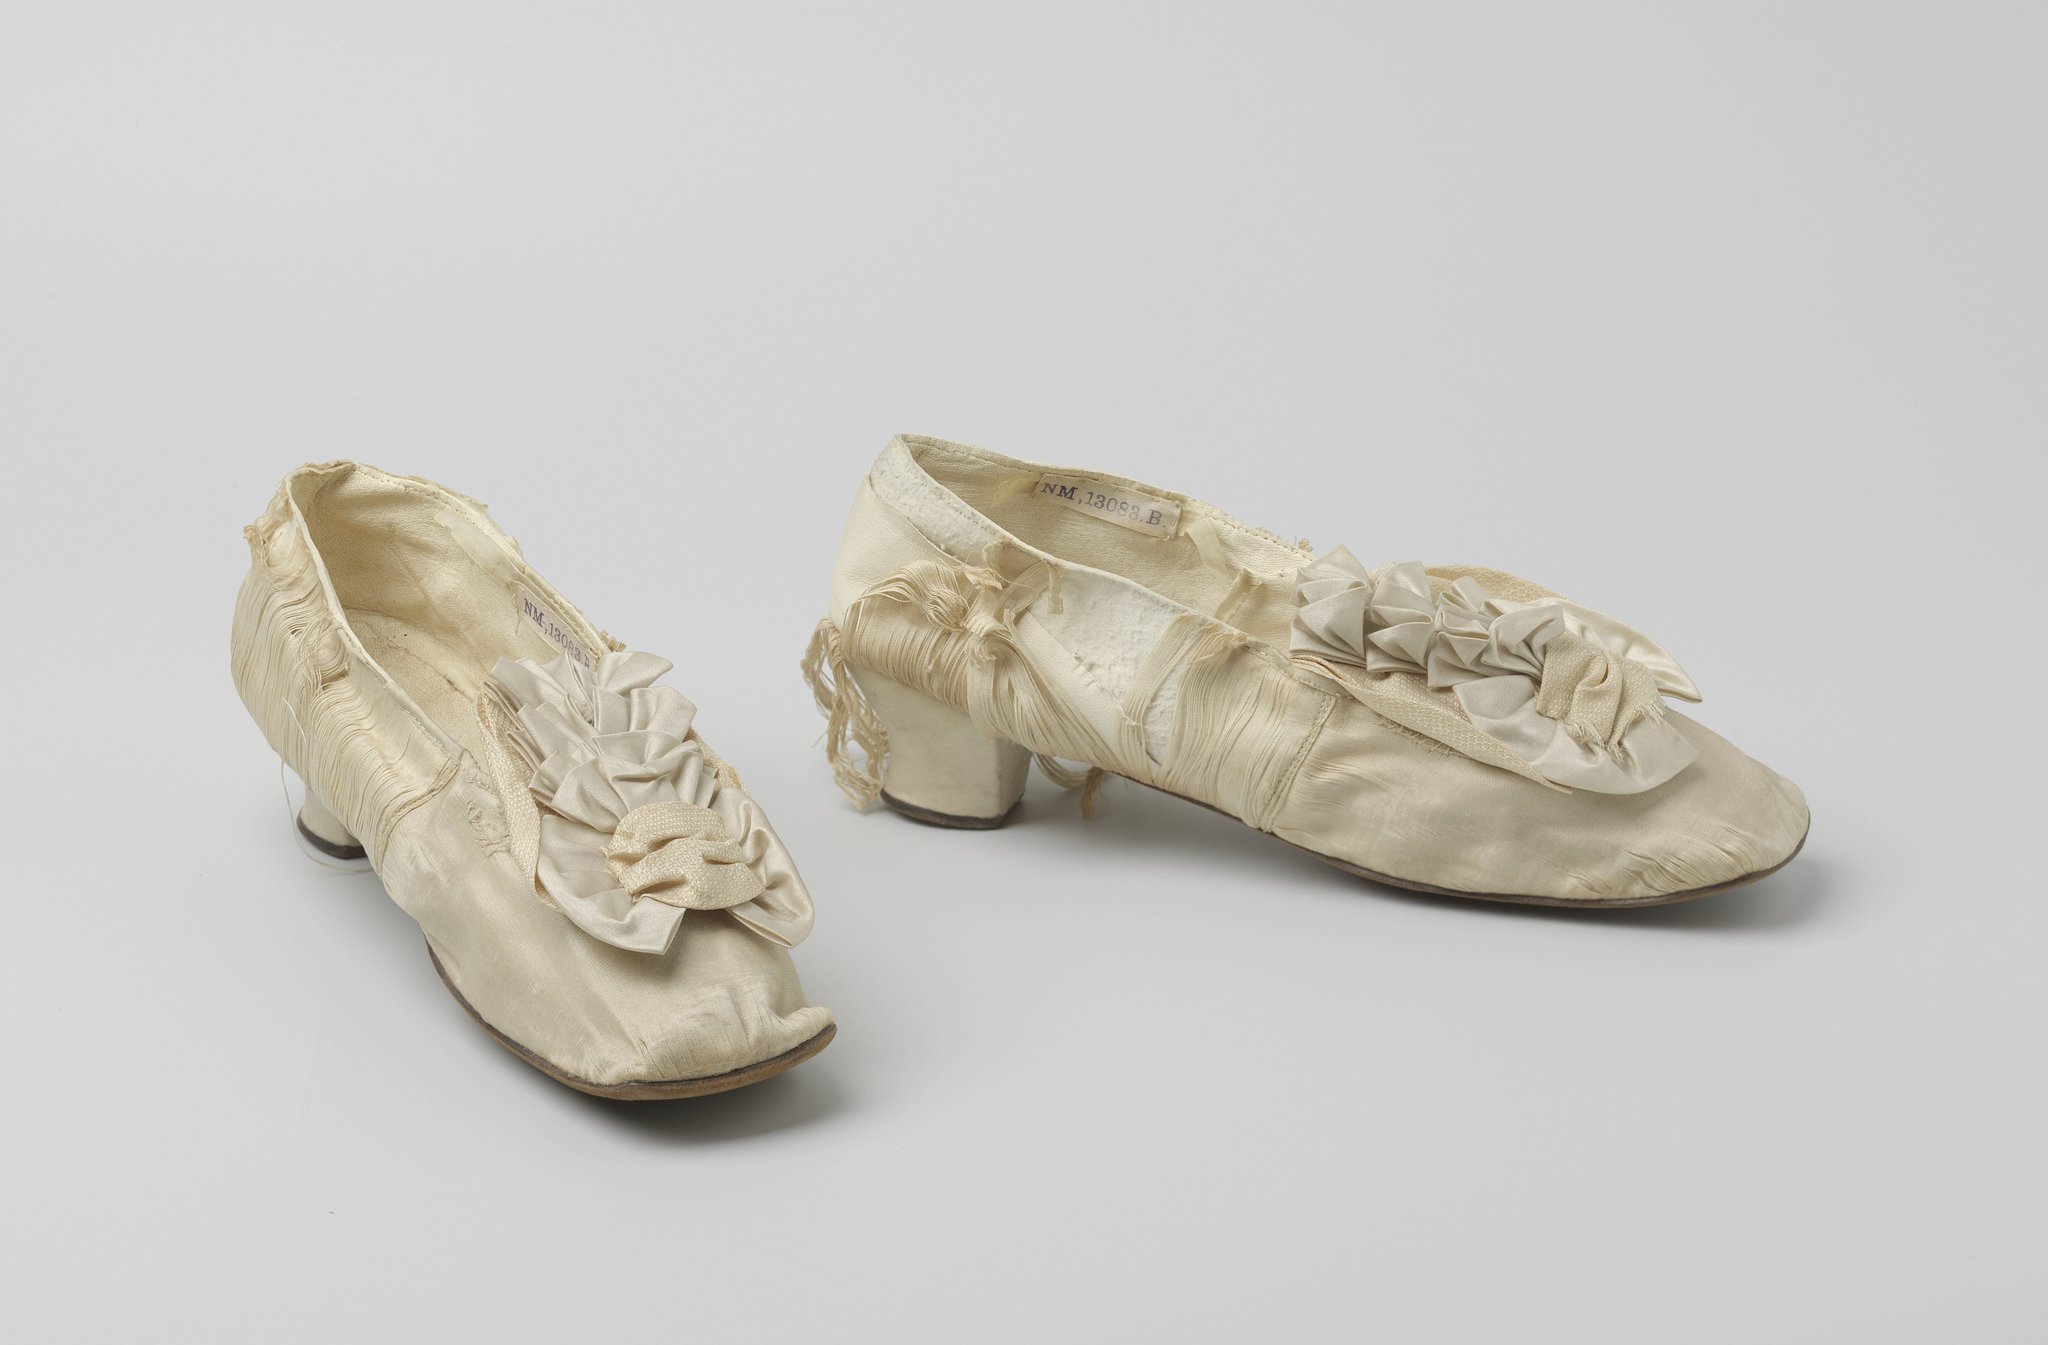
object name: womenswear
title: Balschoen van wit satijn met strikken op de voorschoen, vierkante neus en driekwart hak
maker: Anonymous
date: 1850-1860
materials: leather, textile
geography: netherlands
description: Balschoen van wit satijn met strikken op de voorschoen, vierkante neus en driekwart hak.